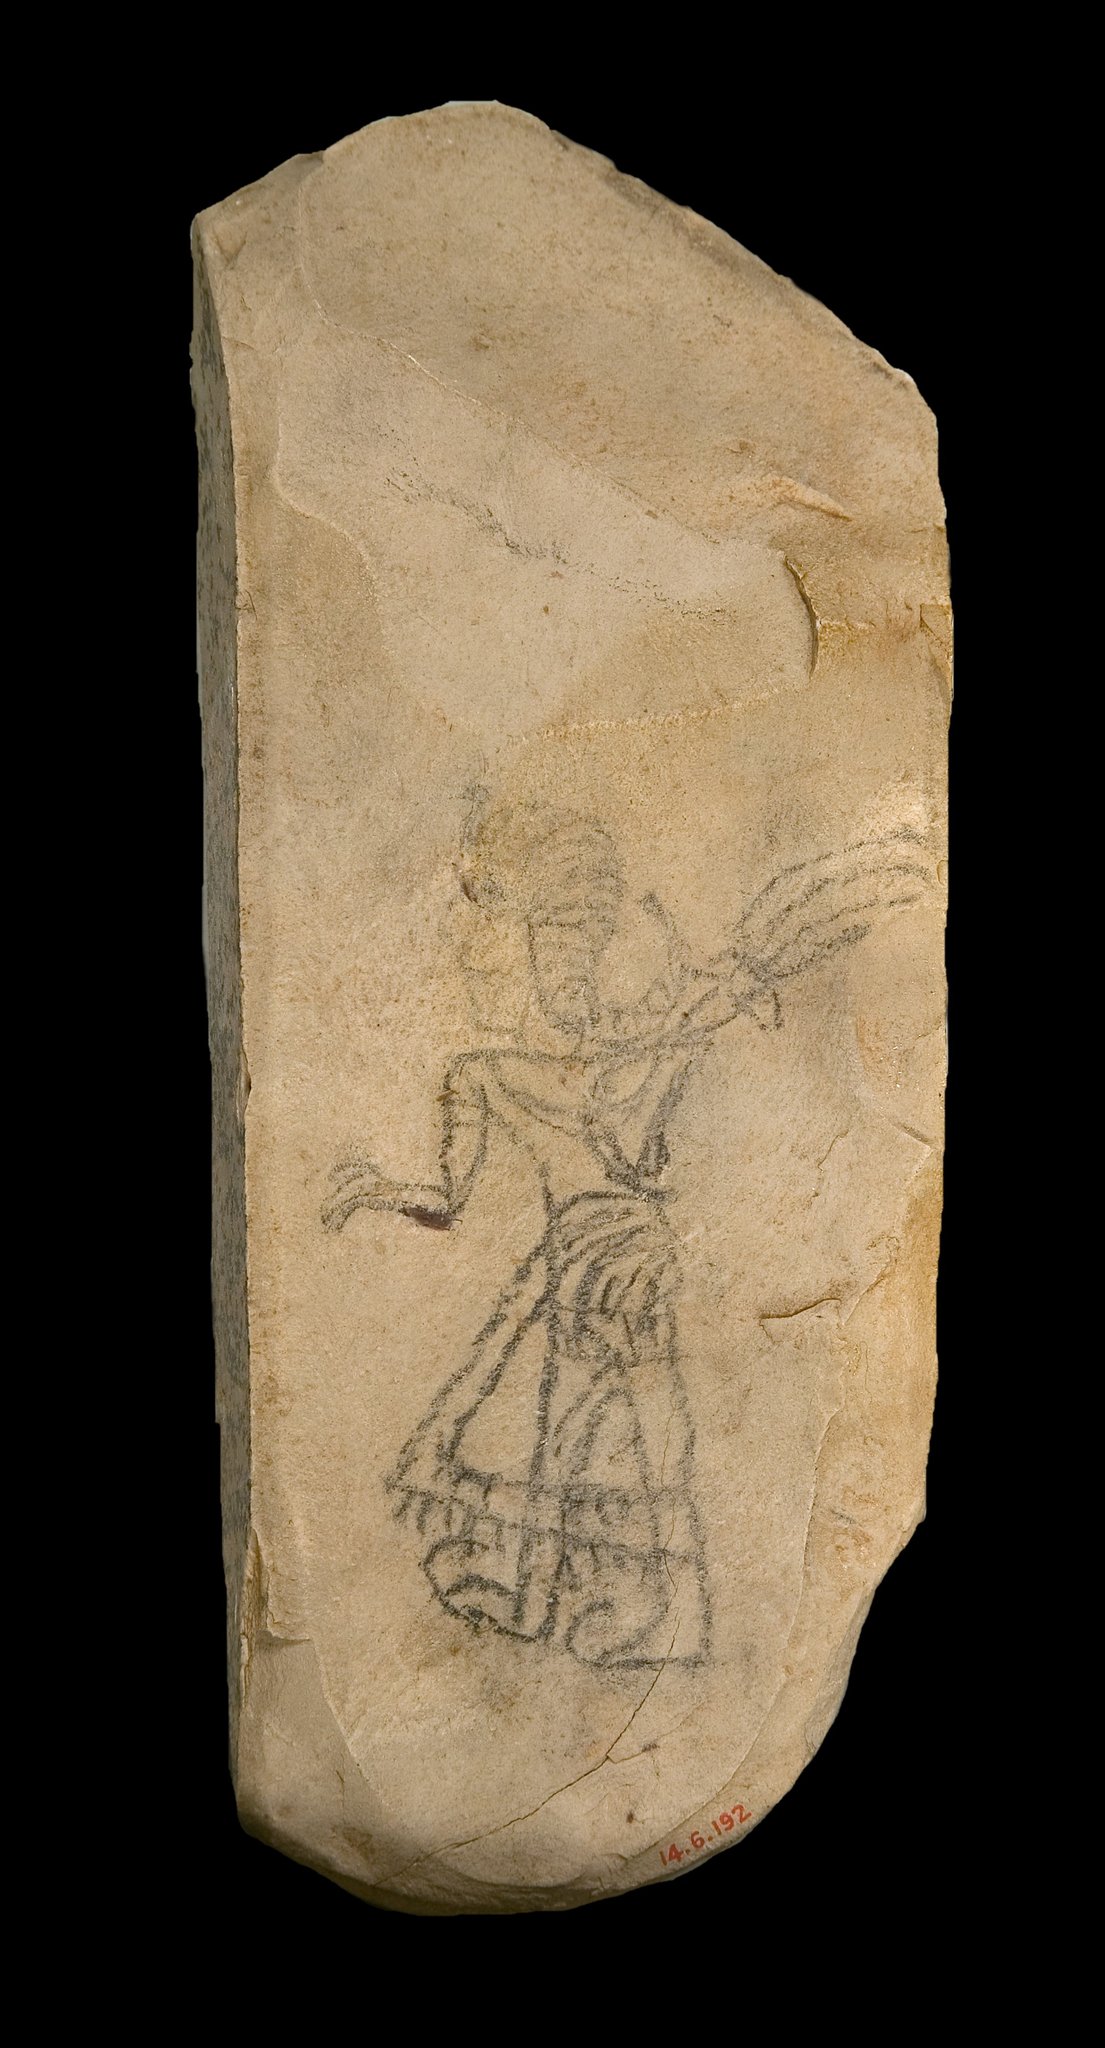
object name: ostracon, standing king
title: Sketch of a King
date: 1295-1070 BCE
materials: ink, limestone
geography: egypt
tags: kings,men